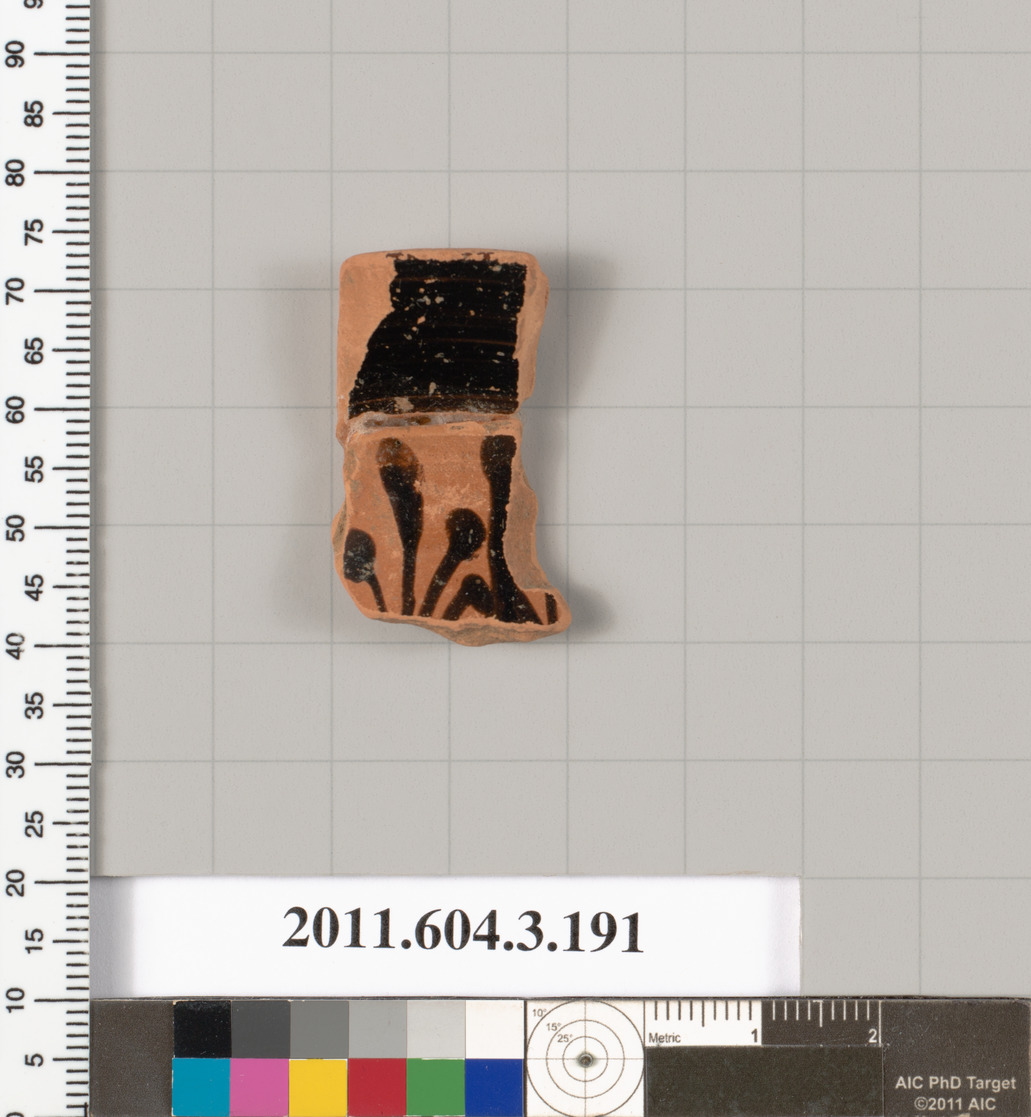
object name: neck amphora fragment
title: Terracotta fragment of a neck-amphora (jar)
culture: greek, attic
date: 510-500 BCE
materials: terracotta